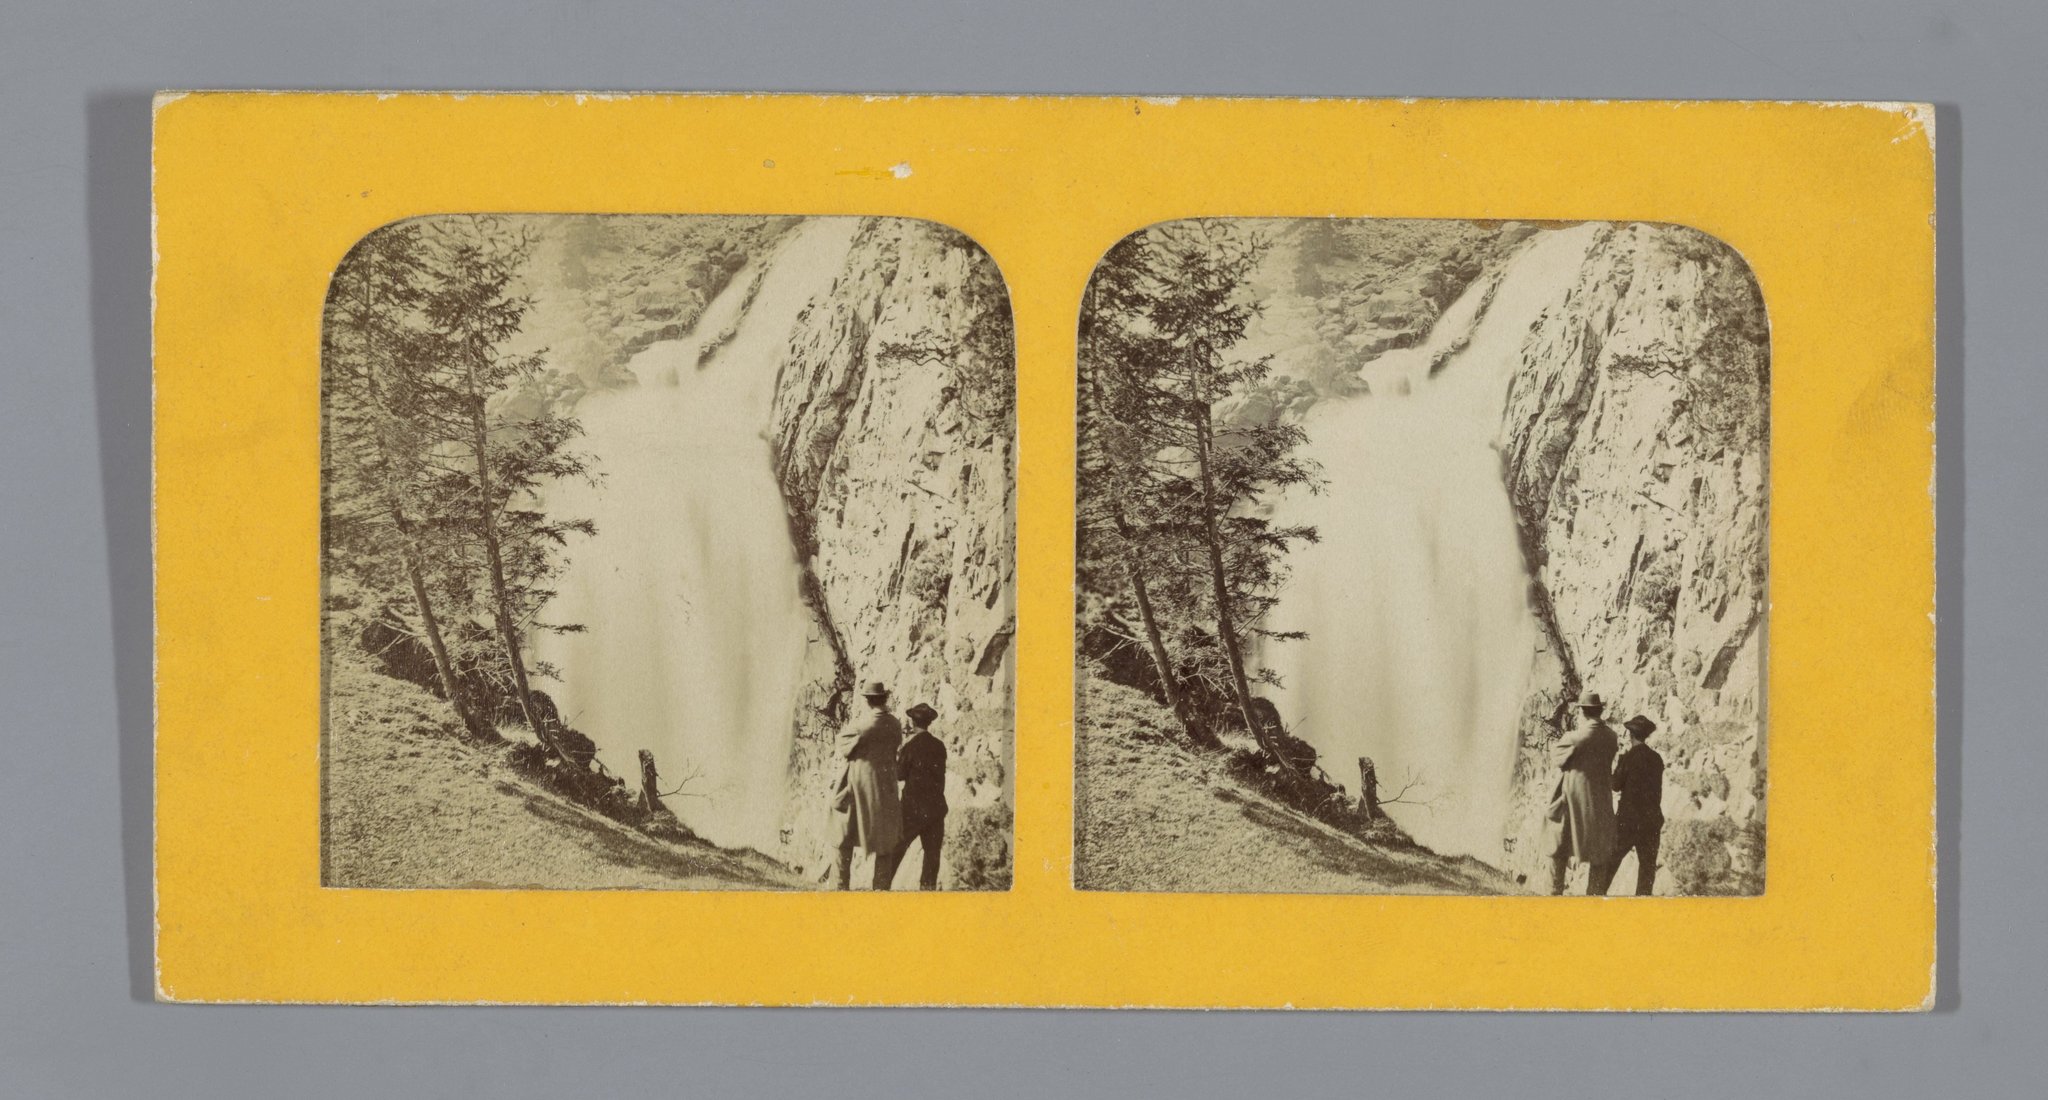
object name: tissue stereograph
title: Waterval van Barberine op de grens van Frankrijk en Zwitserland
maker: Anonymous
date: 1855-1875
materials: cardboard, paper, photographic support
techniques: albumen print, hand coloring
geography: haute-savoie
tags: waterfall (+ landscape with figures, staffage)